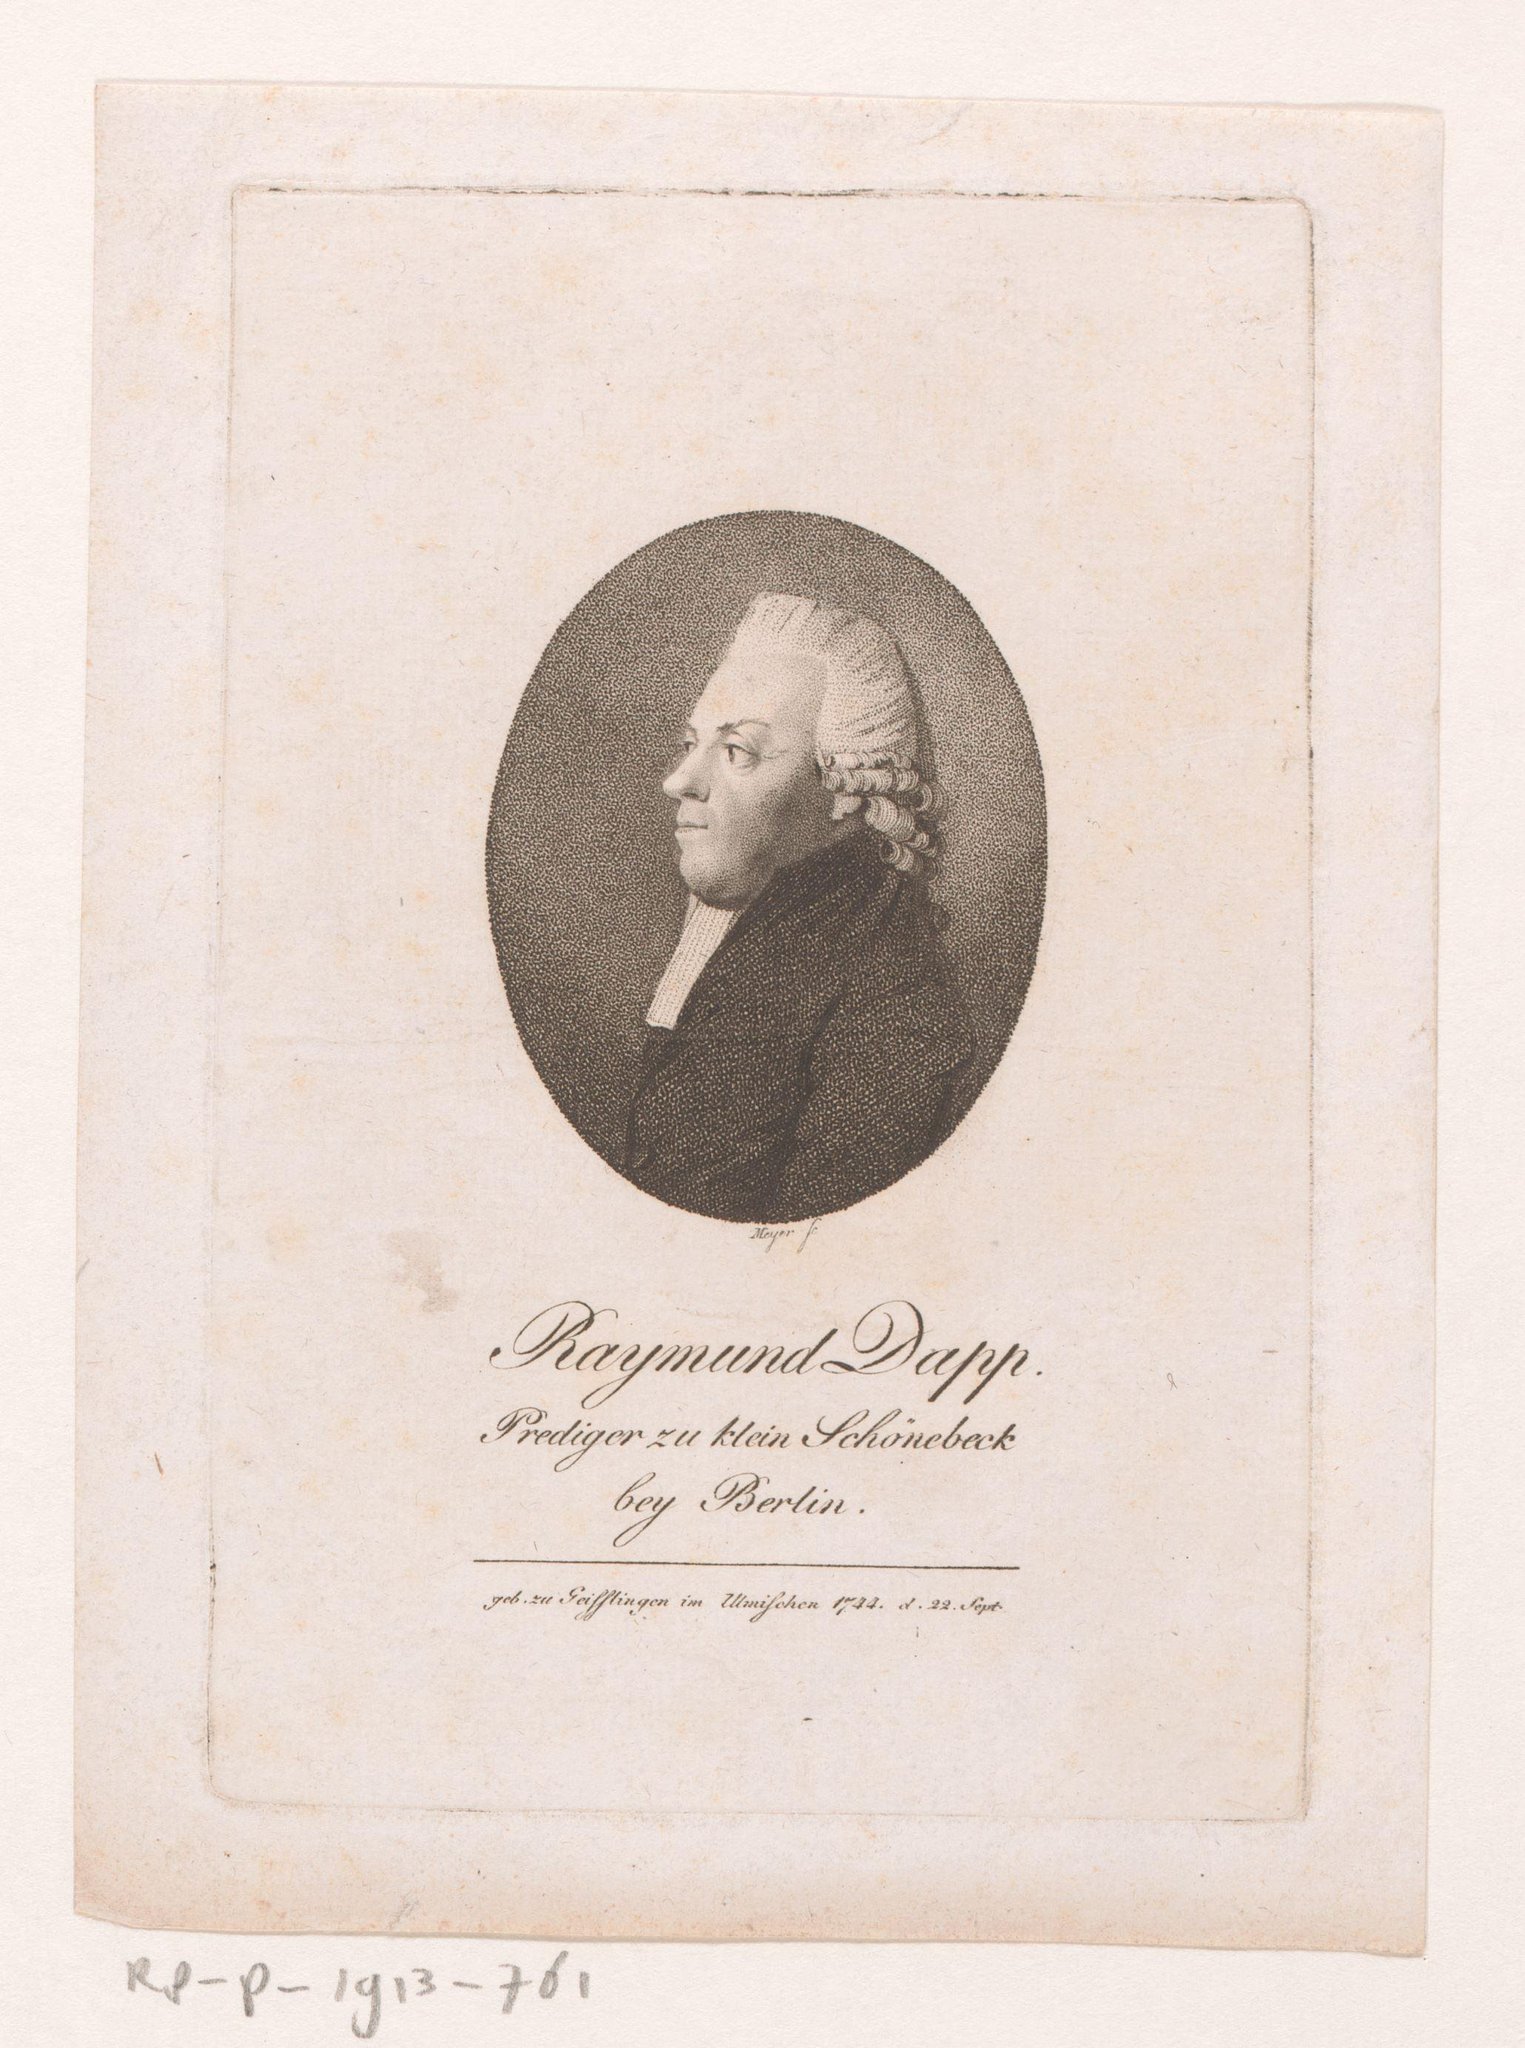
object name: print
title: Portret van Raimund Dapp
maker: friedrich wilhelm meyer (i)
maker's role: print maker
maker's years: 1760-1880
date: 1780-1880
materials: paper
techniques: engraving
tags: historical persons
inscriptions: collector's mark: Lugt 2228